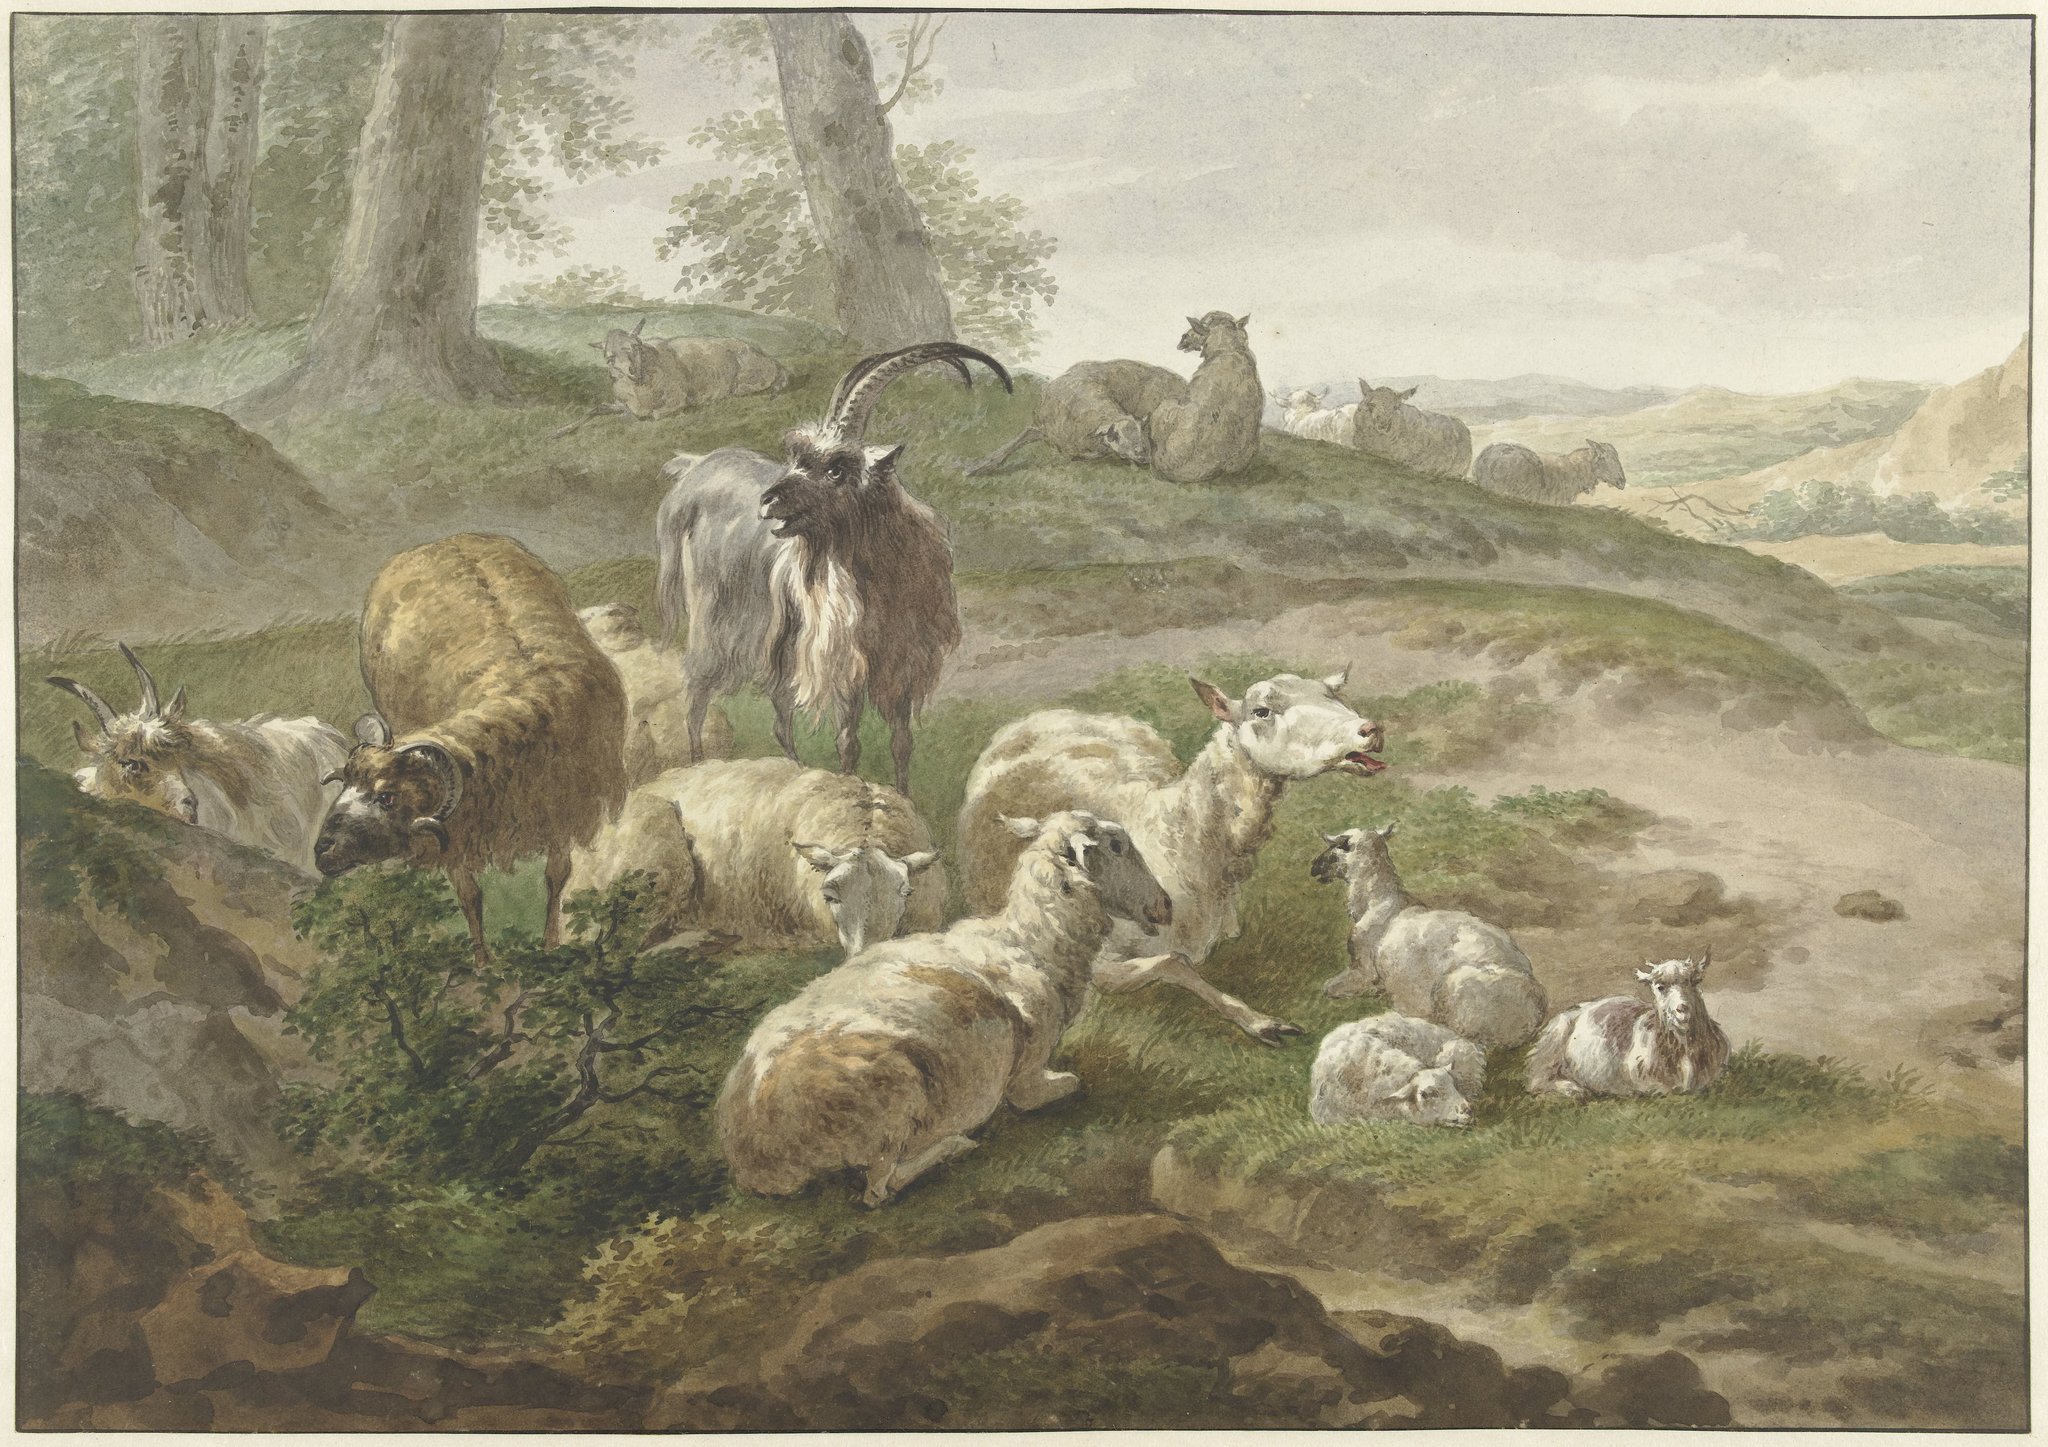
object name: watercolor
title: Bokken en schapen in een heuvelachtig landschap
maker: wybrand hendriks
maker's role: draughtsman, painter, print maker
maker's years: 1744-1831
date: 1754-1831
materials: paper, pencil, watercolor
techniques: brush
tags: cattle